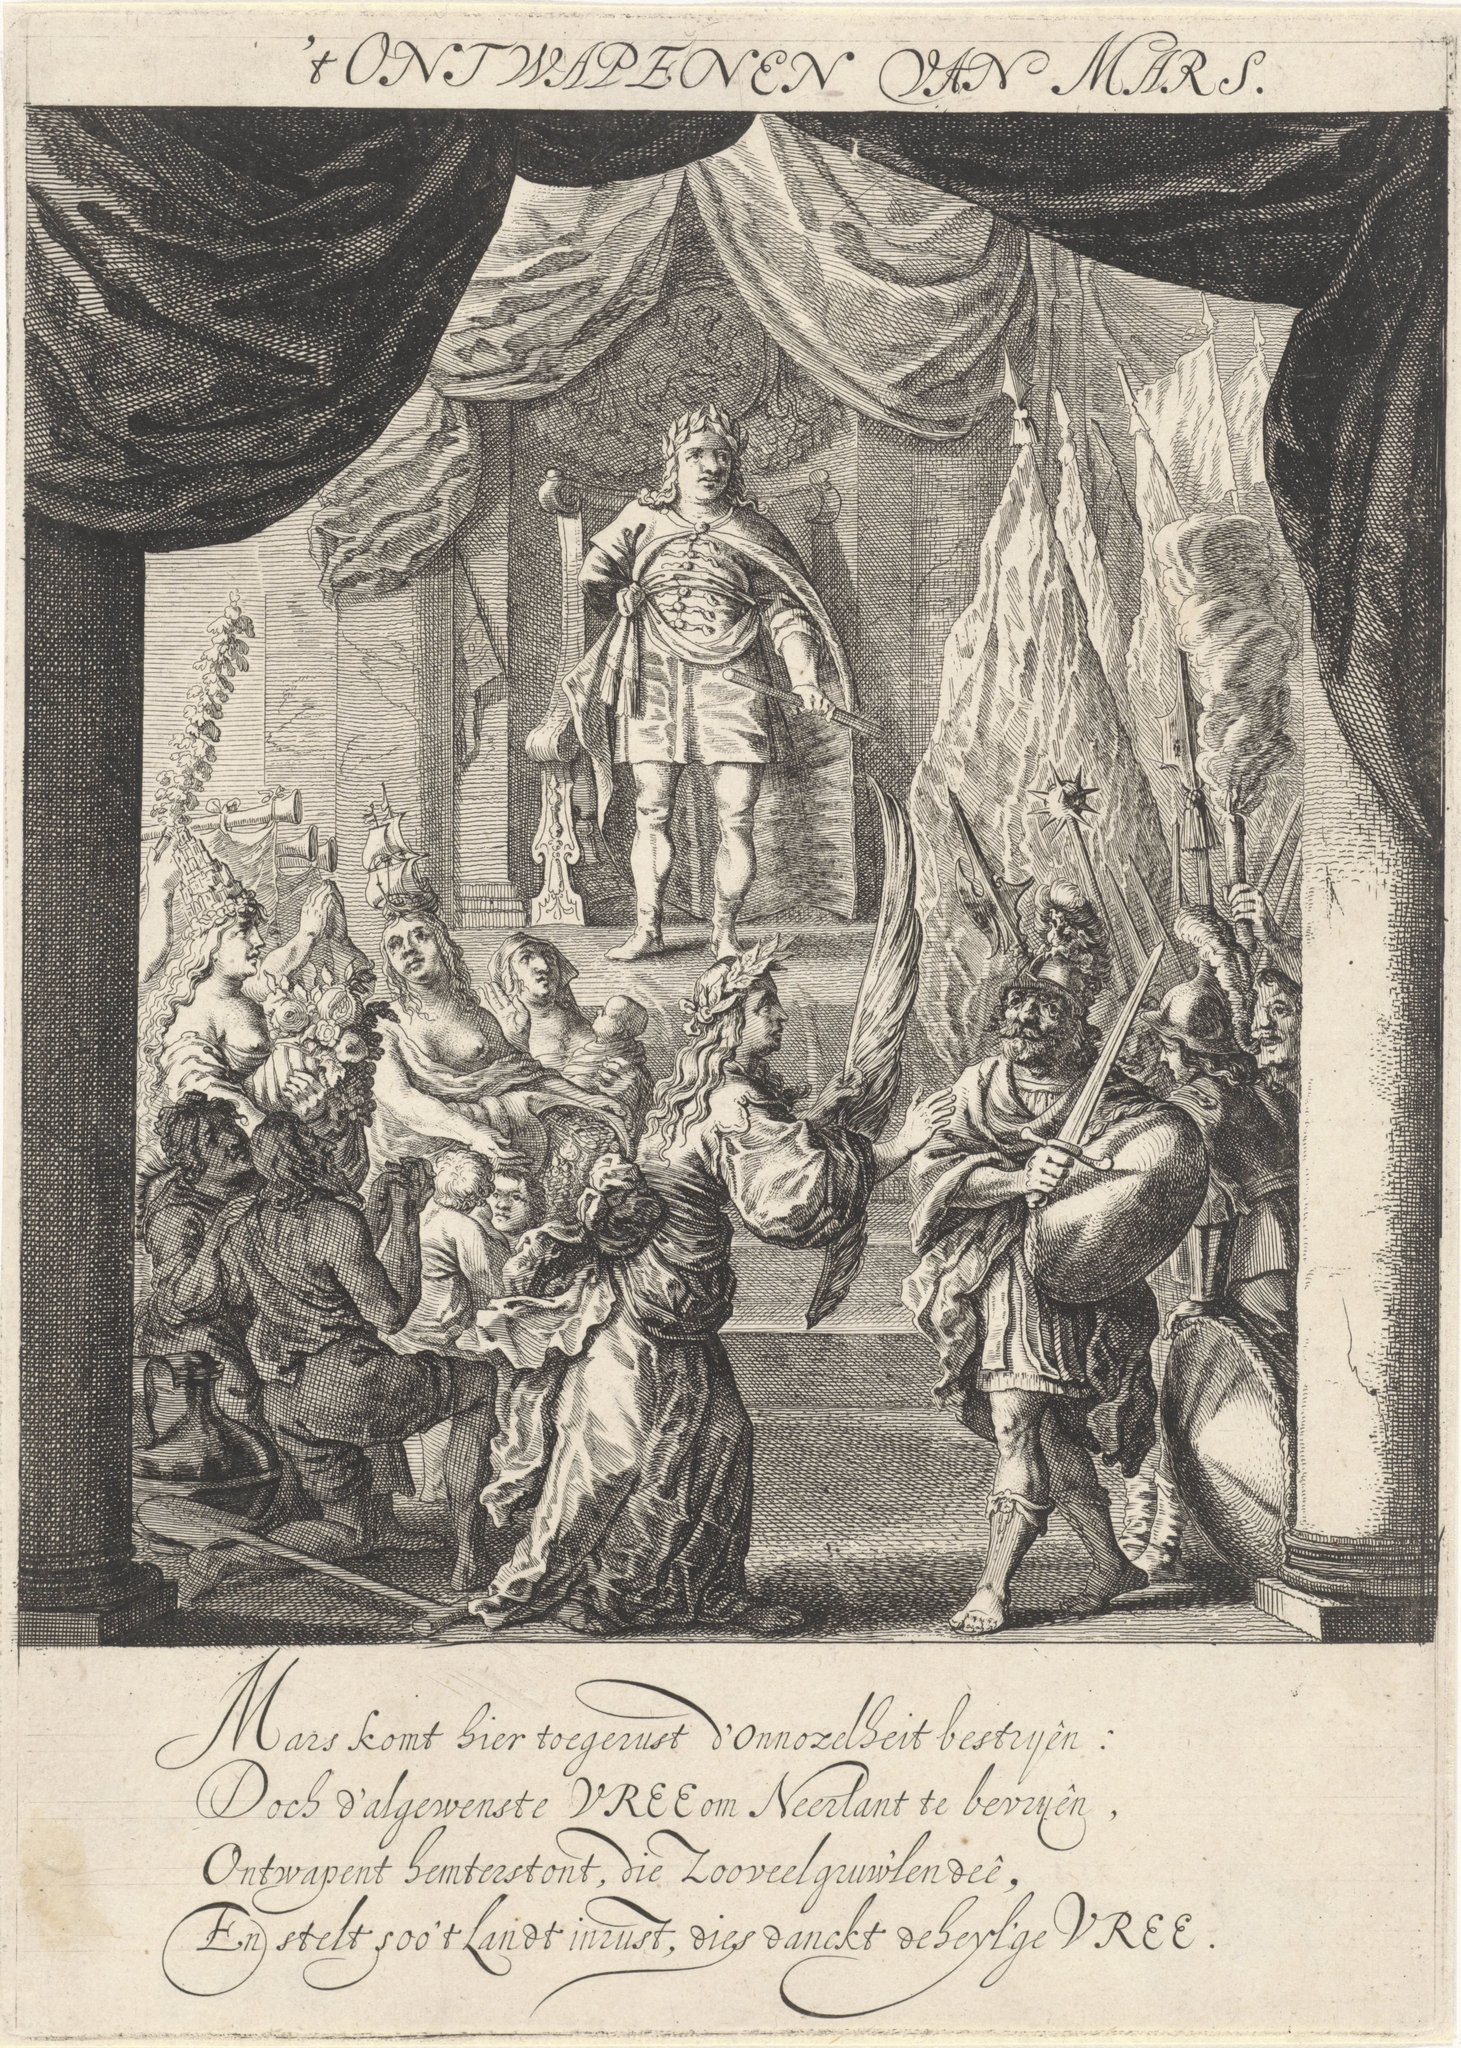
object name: print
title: Vertoning van het Ontwapenen van Mars, 1648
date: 1649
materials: paper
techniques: etching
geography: amsterdam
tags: symbols, allegories of peace, 'pax'; 'pace' (ripa), theatre, theatrical performance, festivities on events of national importance, specific aspects, allegorical aspects of mars; mars as patron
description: Vertoning van het Ontwapenen van Mars. Onderdeel van de vertoningen opgevoerd op 23 juni 1648 op de Schouwburg te Amsterdam naar aanleiding van het sluiten van de Vrede van Munster. De derde voorstelling toont hoe Mars door de Vrede wordt ontwapend. Op de achtergrond kijkt een Hollandse vorst toe. In het onderschrift een vers van 4 regels in het Nederlands.